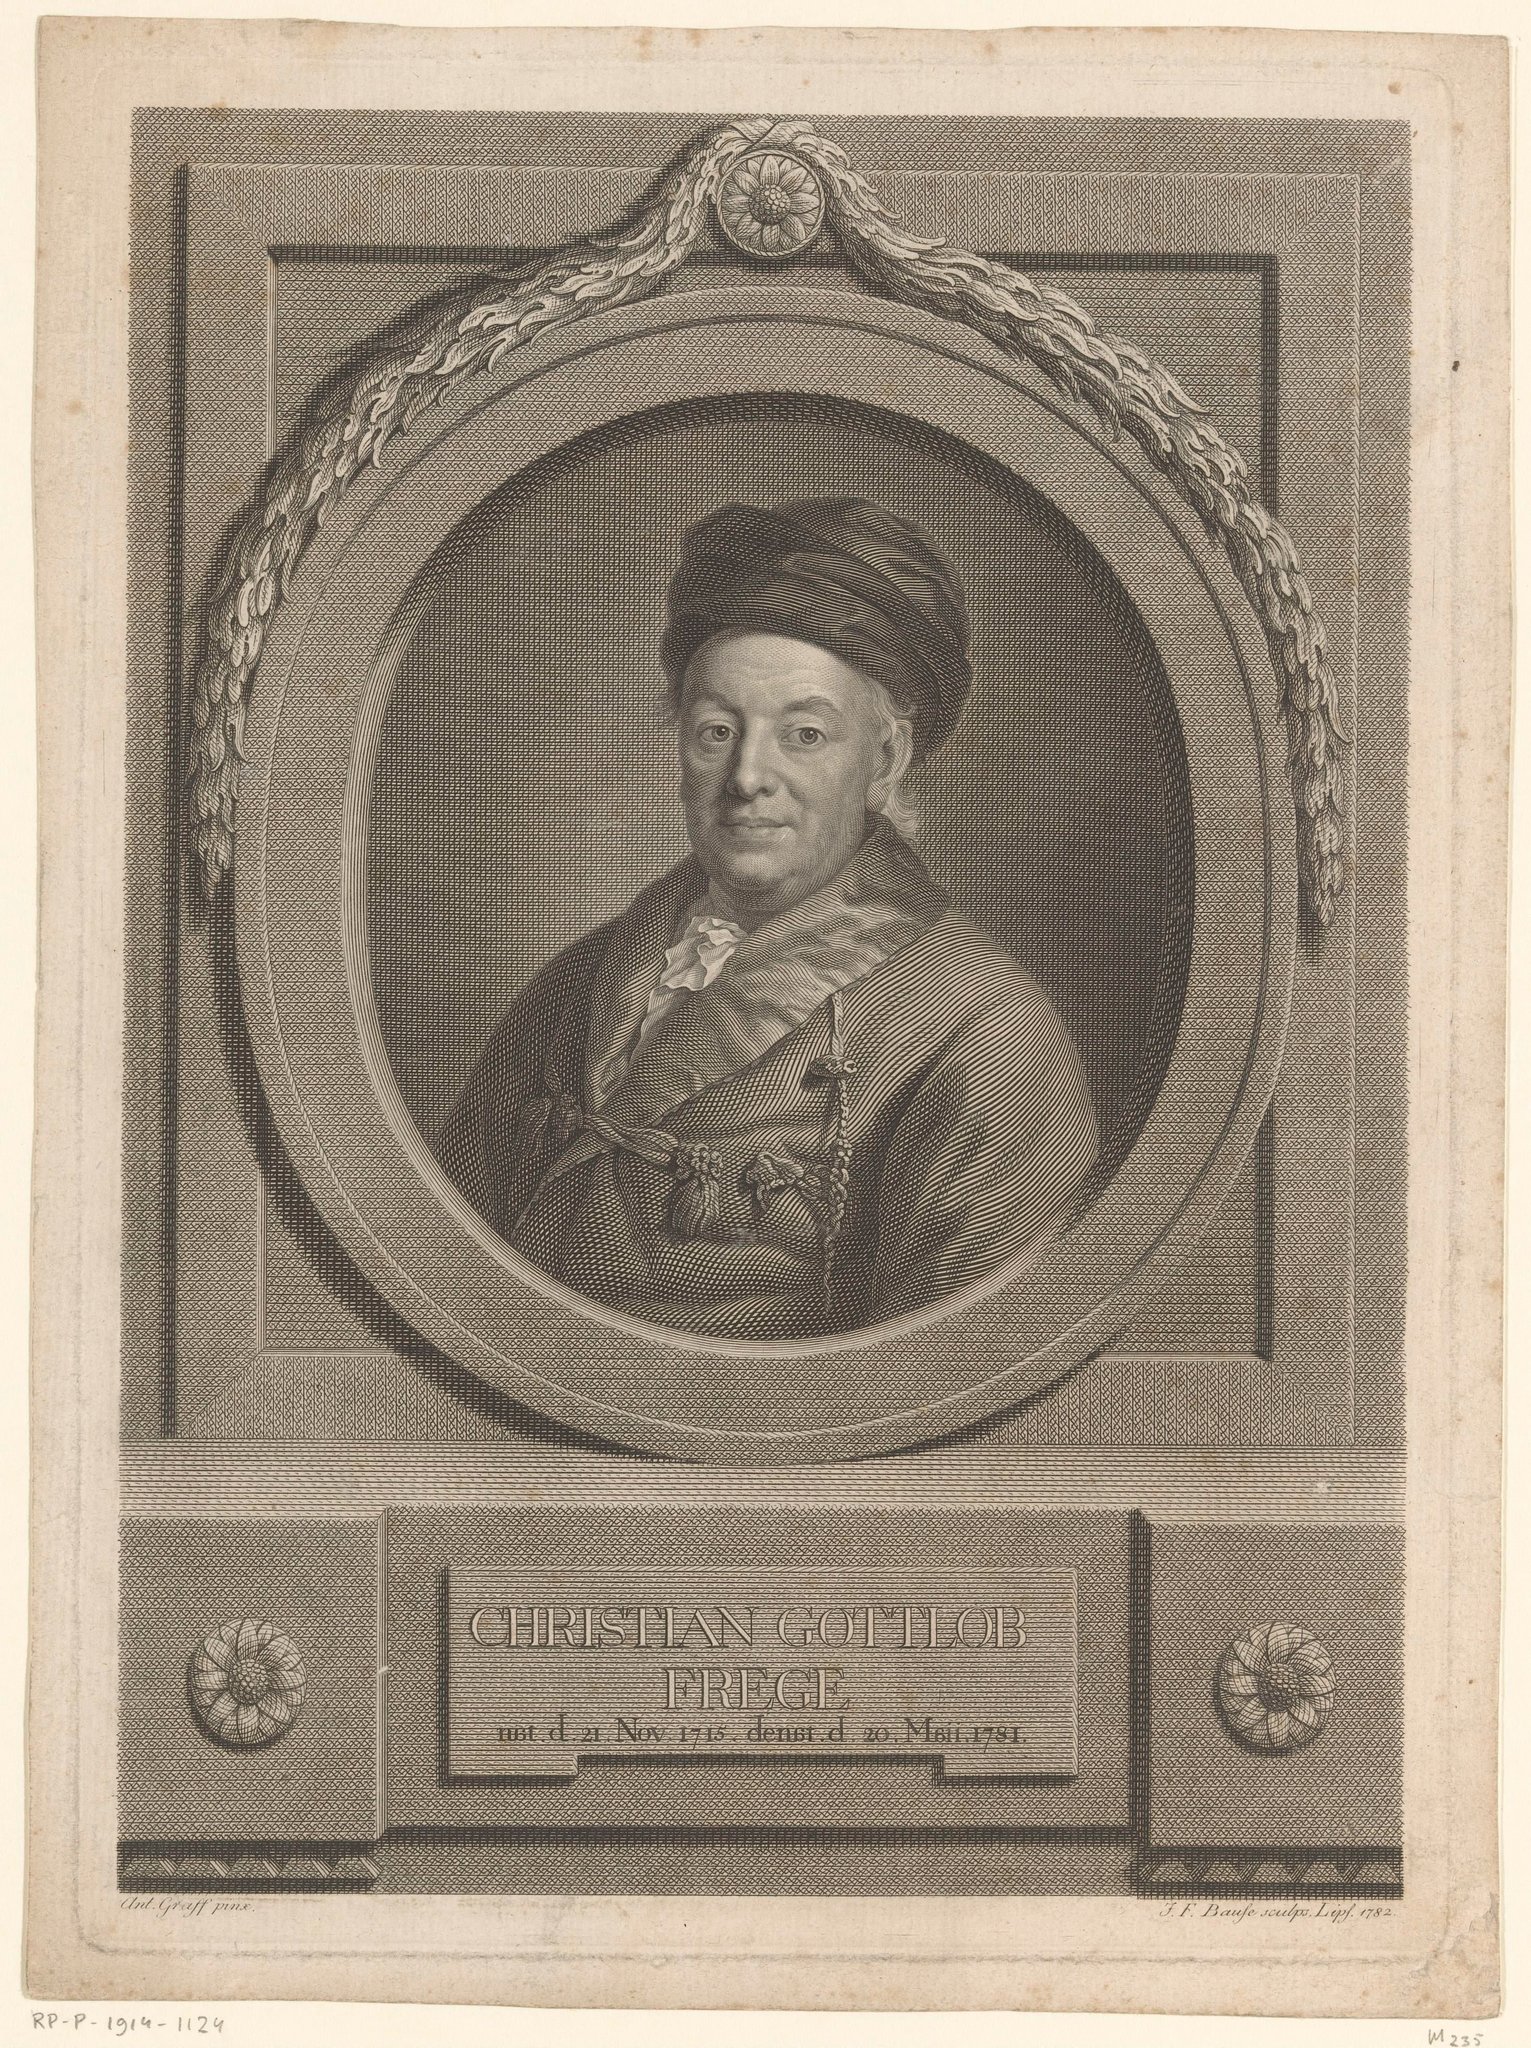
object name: print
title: Portret van Christian Gottlob Frege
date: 1782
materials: paper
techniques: engraving, etching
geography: leipzig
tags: historical persons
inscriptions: collector's mark: Lugt 2228